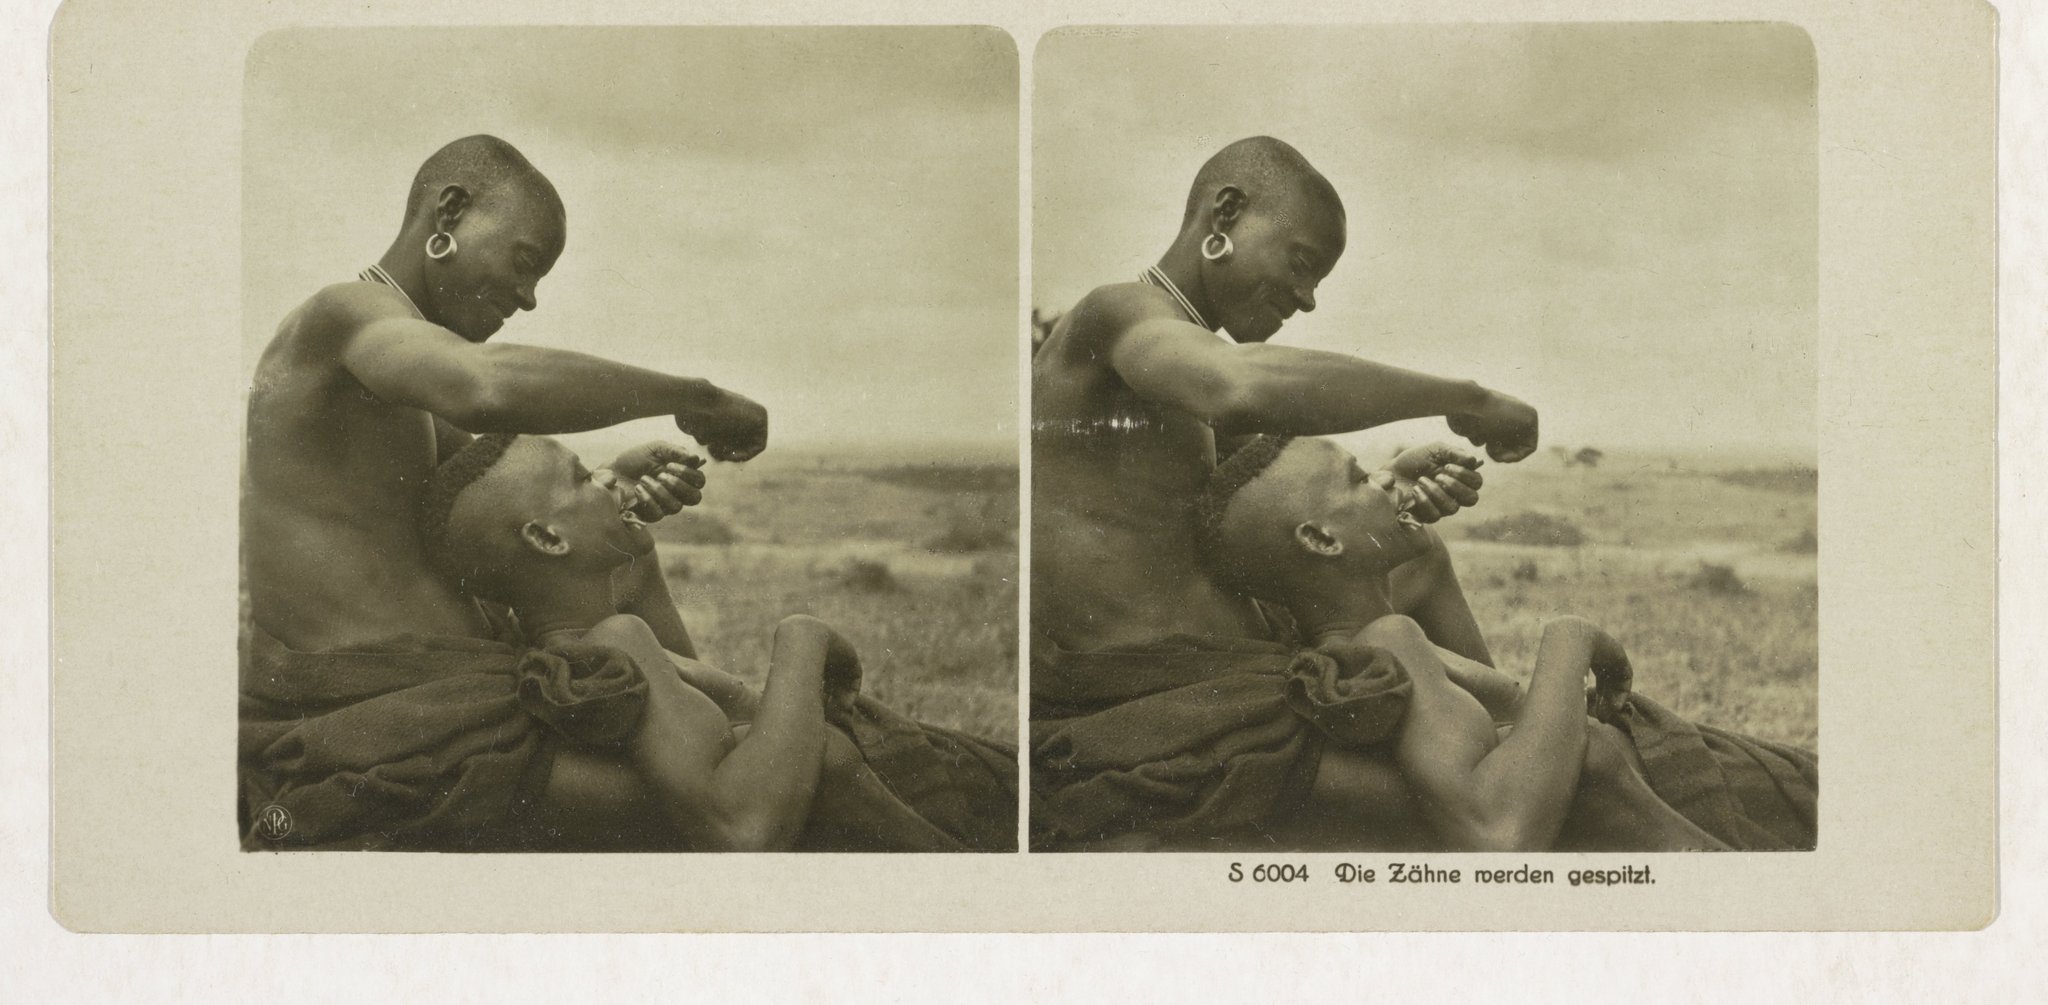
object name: stereograph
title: Die Zähne werden gespitzt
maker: Anonymous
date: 1898-1935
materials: paper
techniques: gelatin silver print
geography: berlin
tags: care of the body, hygiene, teeth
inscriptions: monogram: ‘NPG’, number: ‘S 6004’